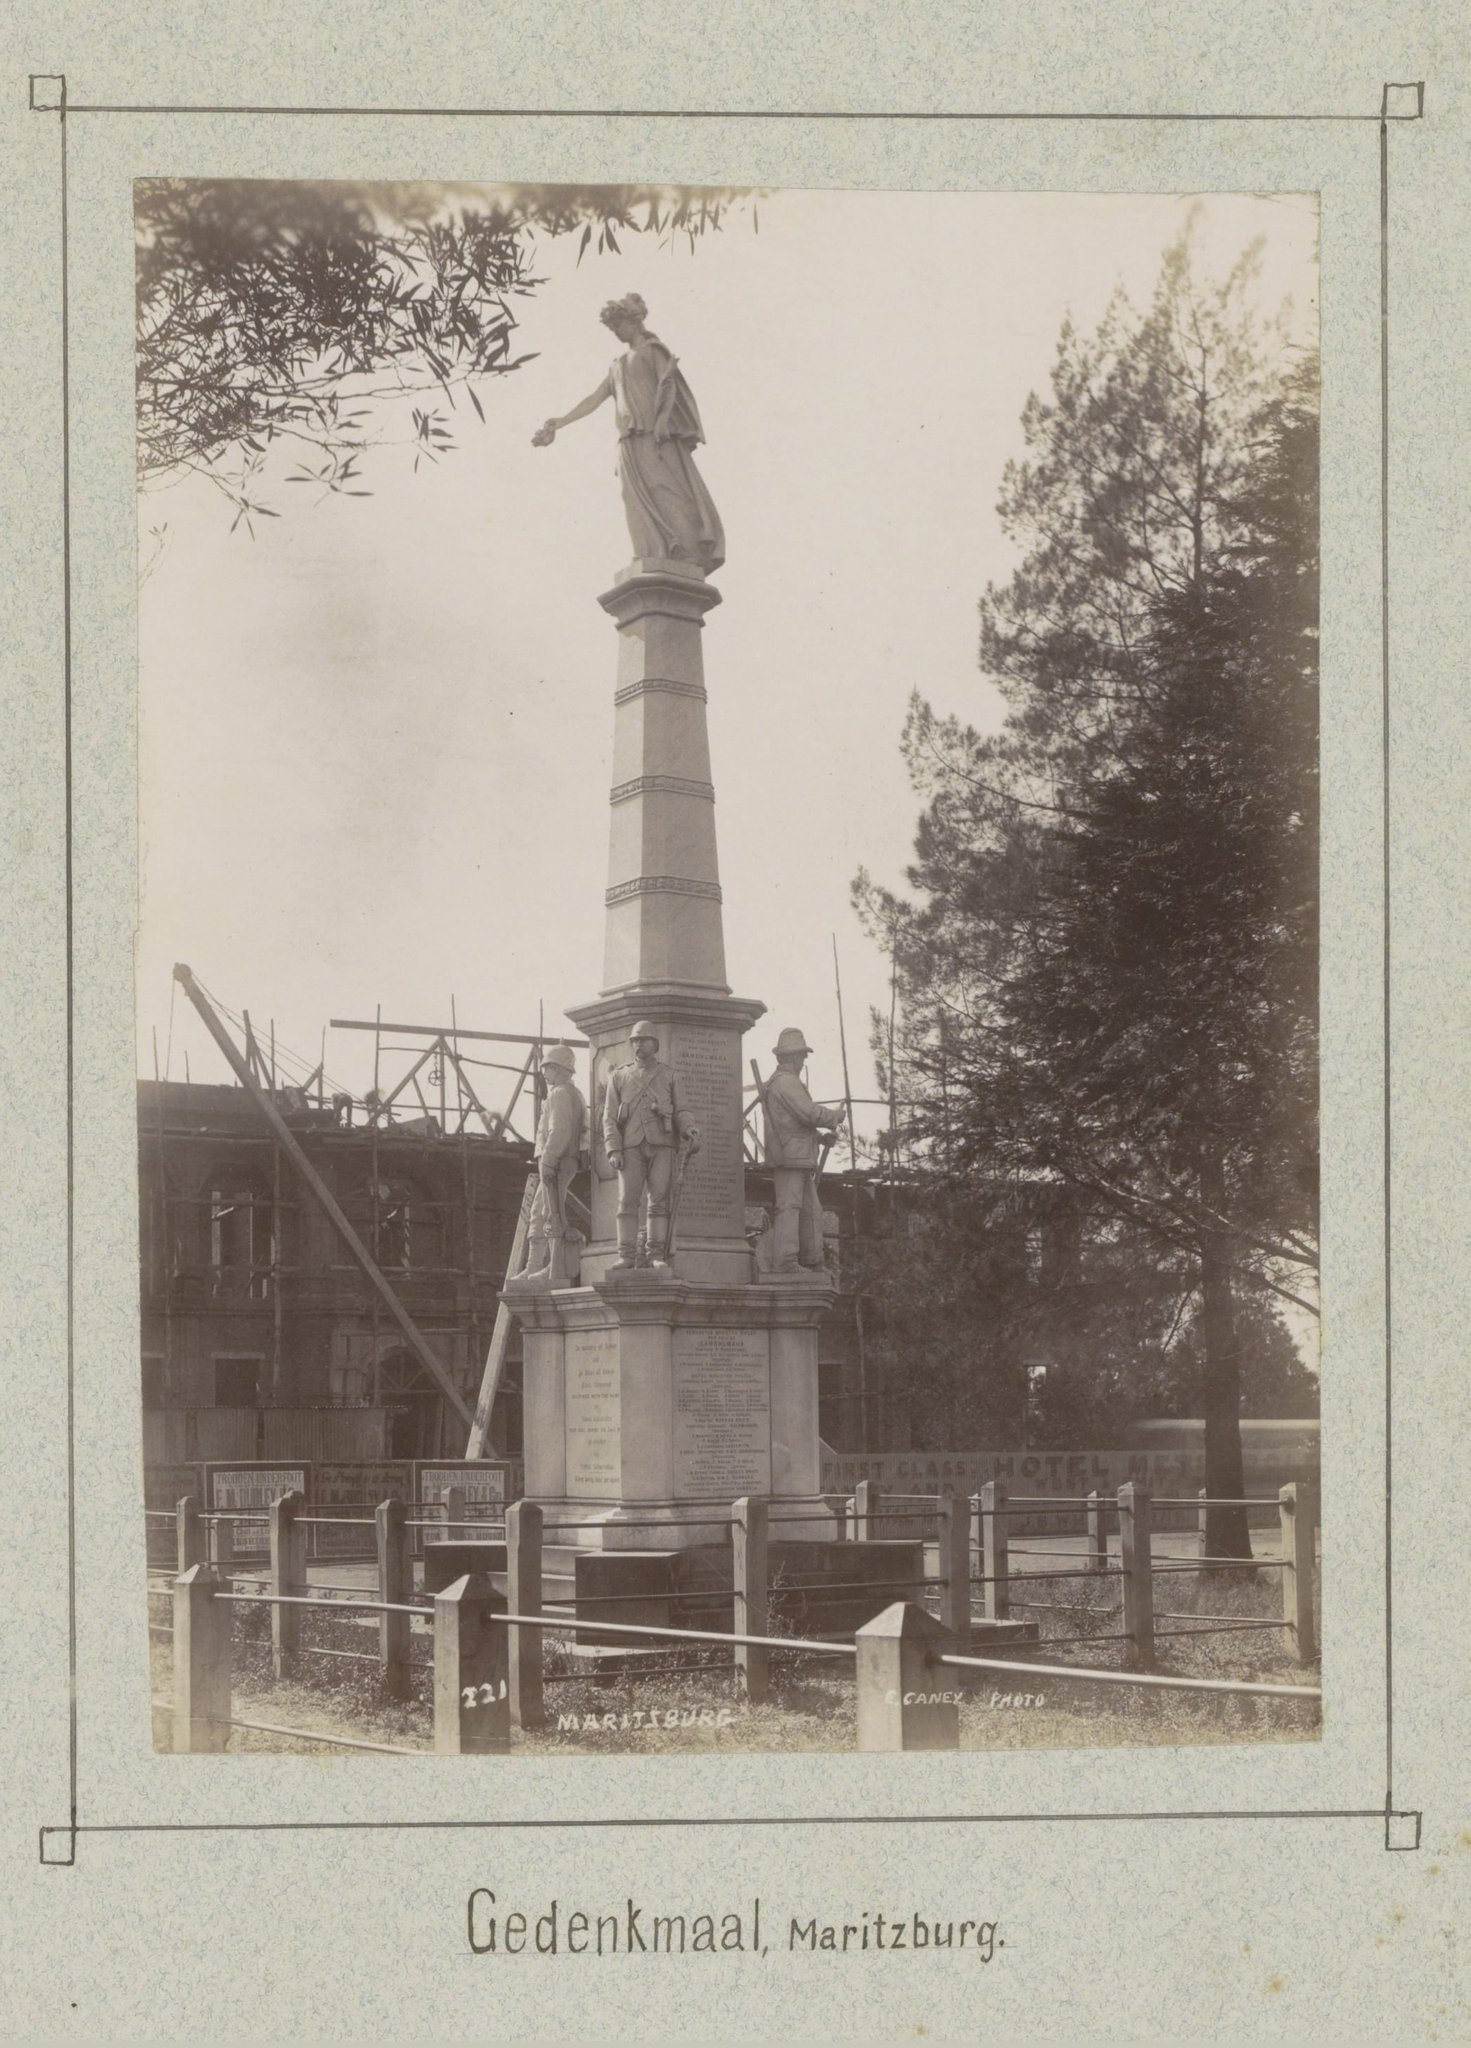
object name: photograph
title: Monument ter nagedachtenis van de gevallenen in de Zoeloe-oorlog van 1879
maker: ebenezer edmund caney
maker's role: fotograaf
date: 1879-1900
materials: photographic support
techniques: albumen print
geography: pietermaritzburg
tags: monument, statue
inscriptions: inscription: ‘Maritsburg’, number: ‘221’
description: Onderdeel van Reisalbum met foto's van Zuid-Afrika, Madeira, Portugal, Frankrijk en Duitsland.